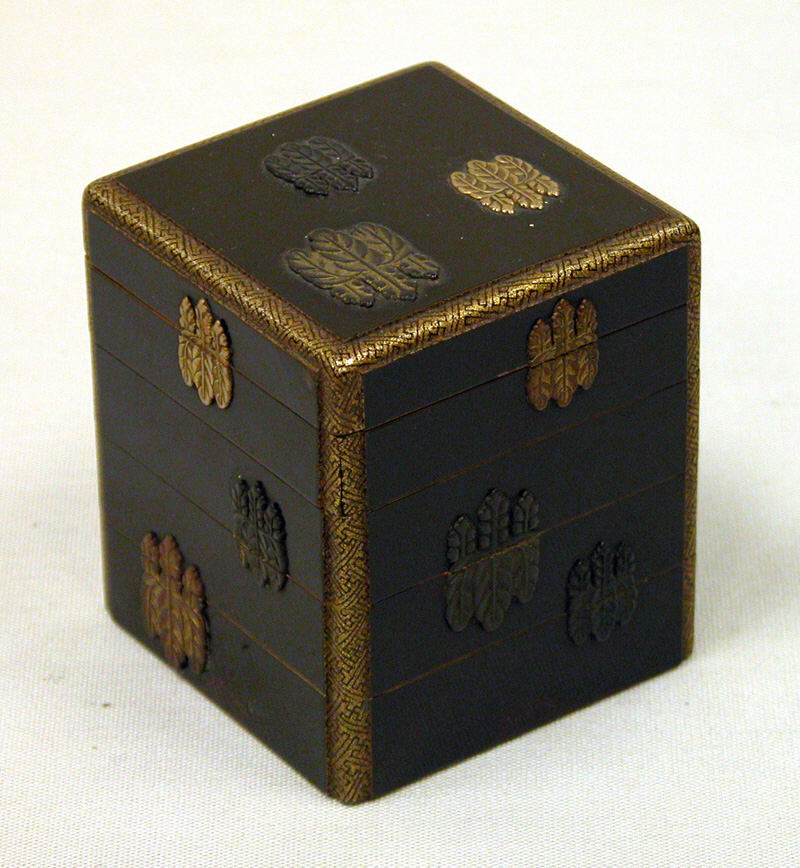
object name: boxe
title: Box of Four Trays with Design of Paulownia Crest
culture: japanese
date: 1701-1800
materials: copper, gold, lacquer, silver